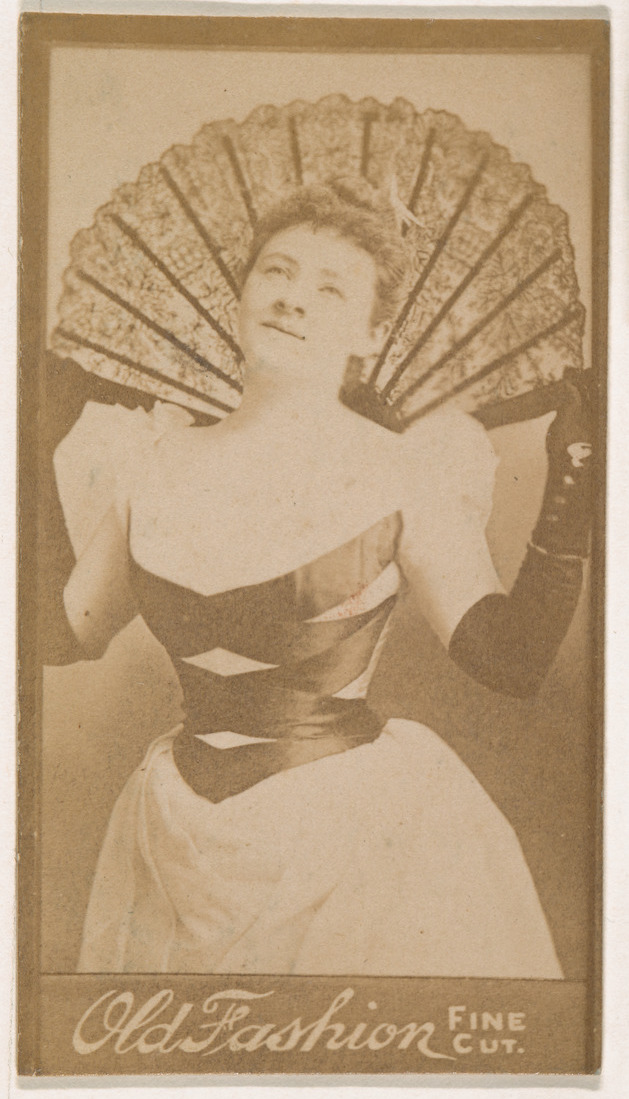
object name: photograph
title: Actress holding large fan, from the Actresses series (N664) promoting Old Fashion Fine Cut Tobacco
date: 1888-1890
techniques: albumen silver print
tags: fans,portraits,women,actresses